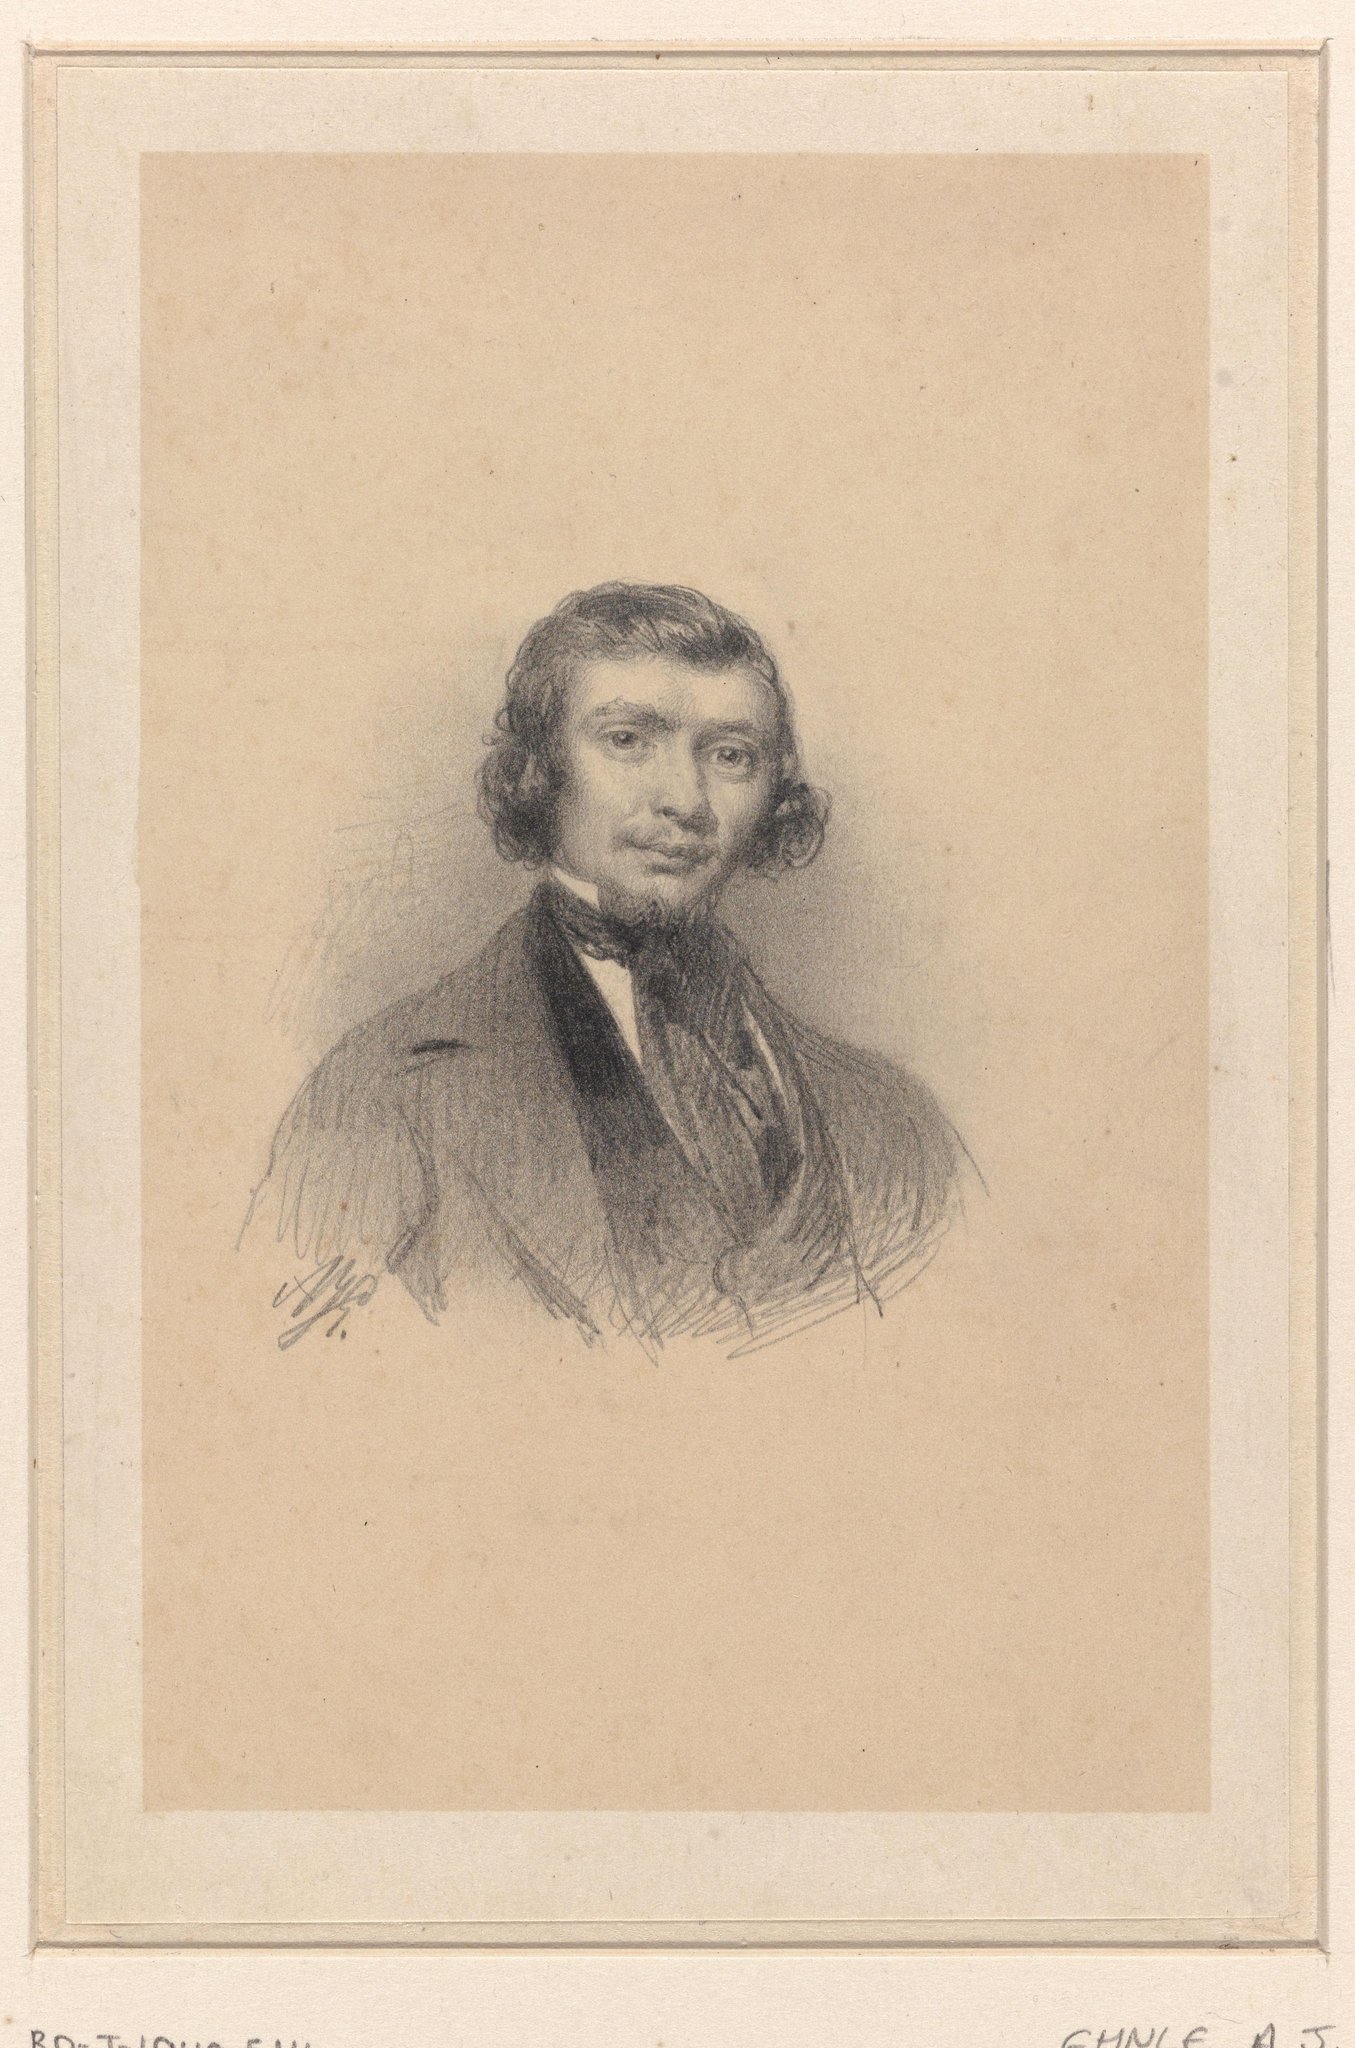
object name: drawing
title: Portret van Antonie Franciscus Dona (Pieck)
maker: Anonymous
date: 1800-1900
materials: chalk, paper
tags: the hague, draughtsman, antonie franciscus dona, historical persons, portrait, self-portrait of painter, portrait, self-portrait of artist, portrait, self-portrait of draughtsman